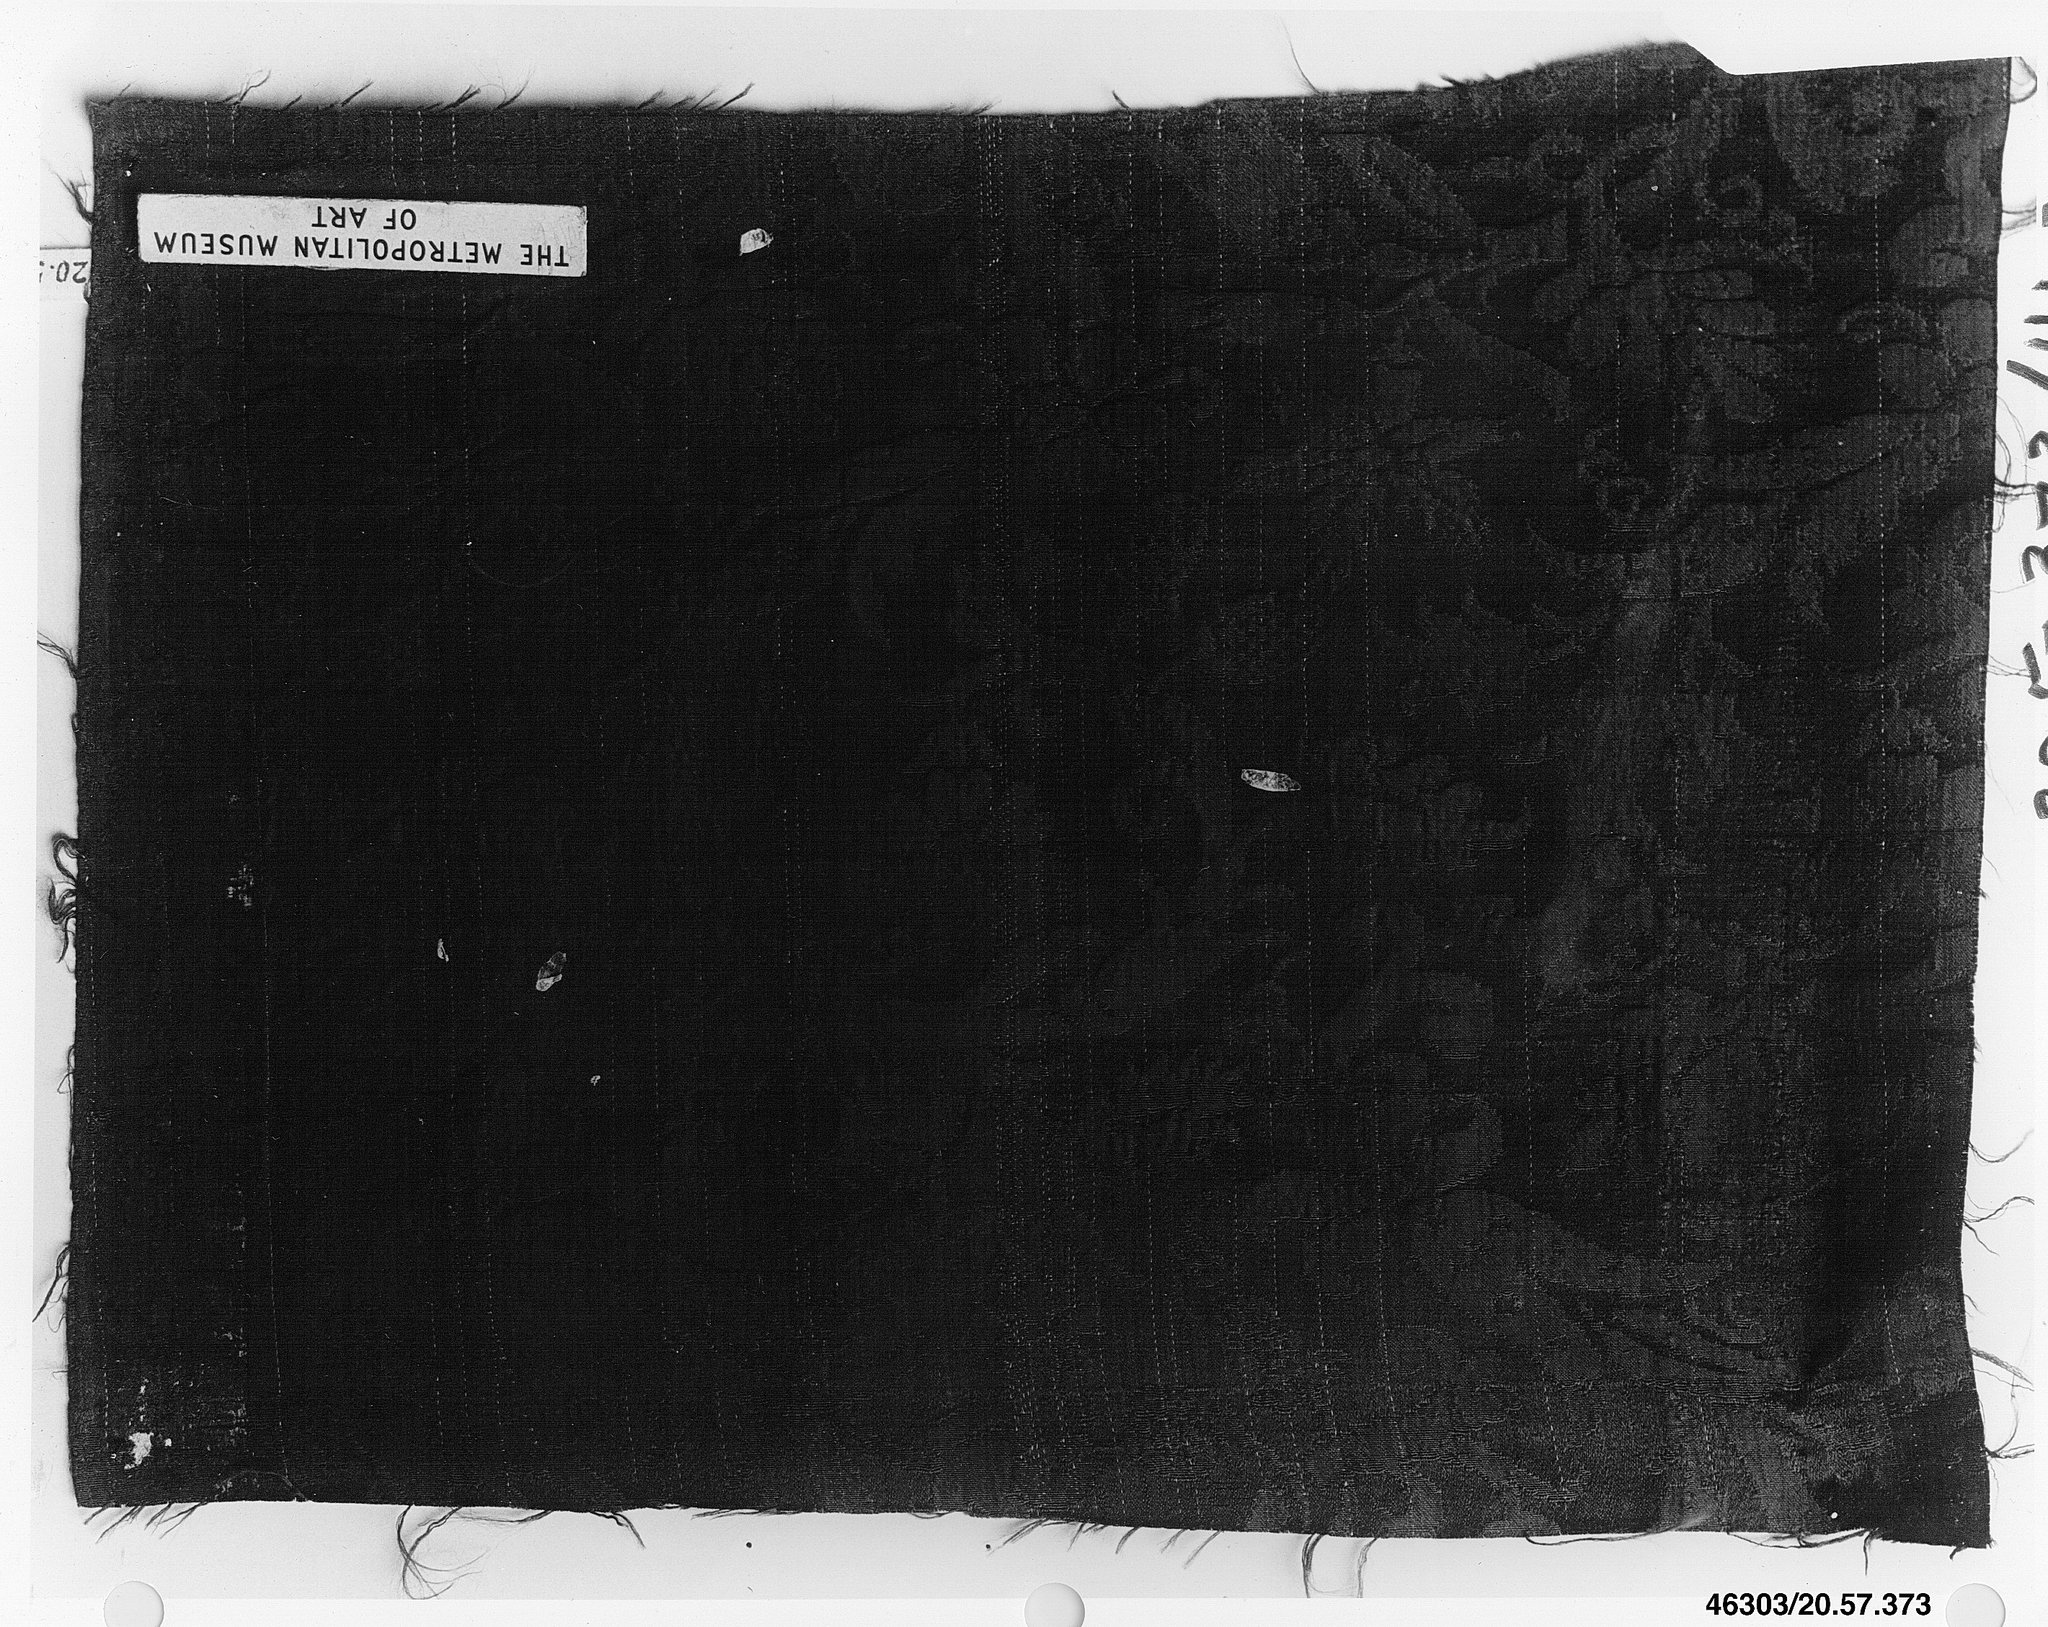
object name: piece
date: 1640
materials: silk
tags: leaves